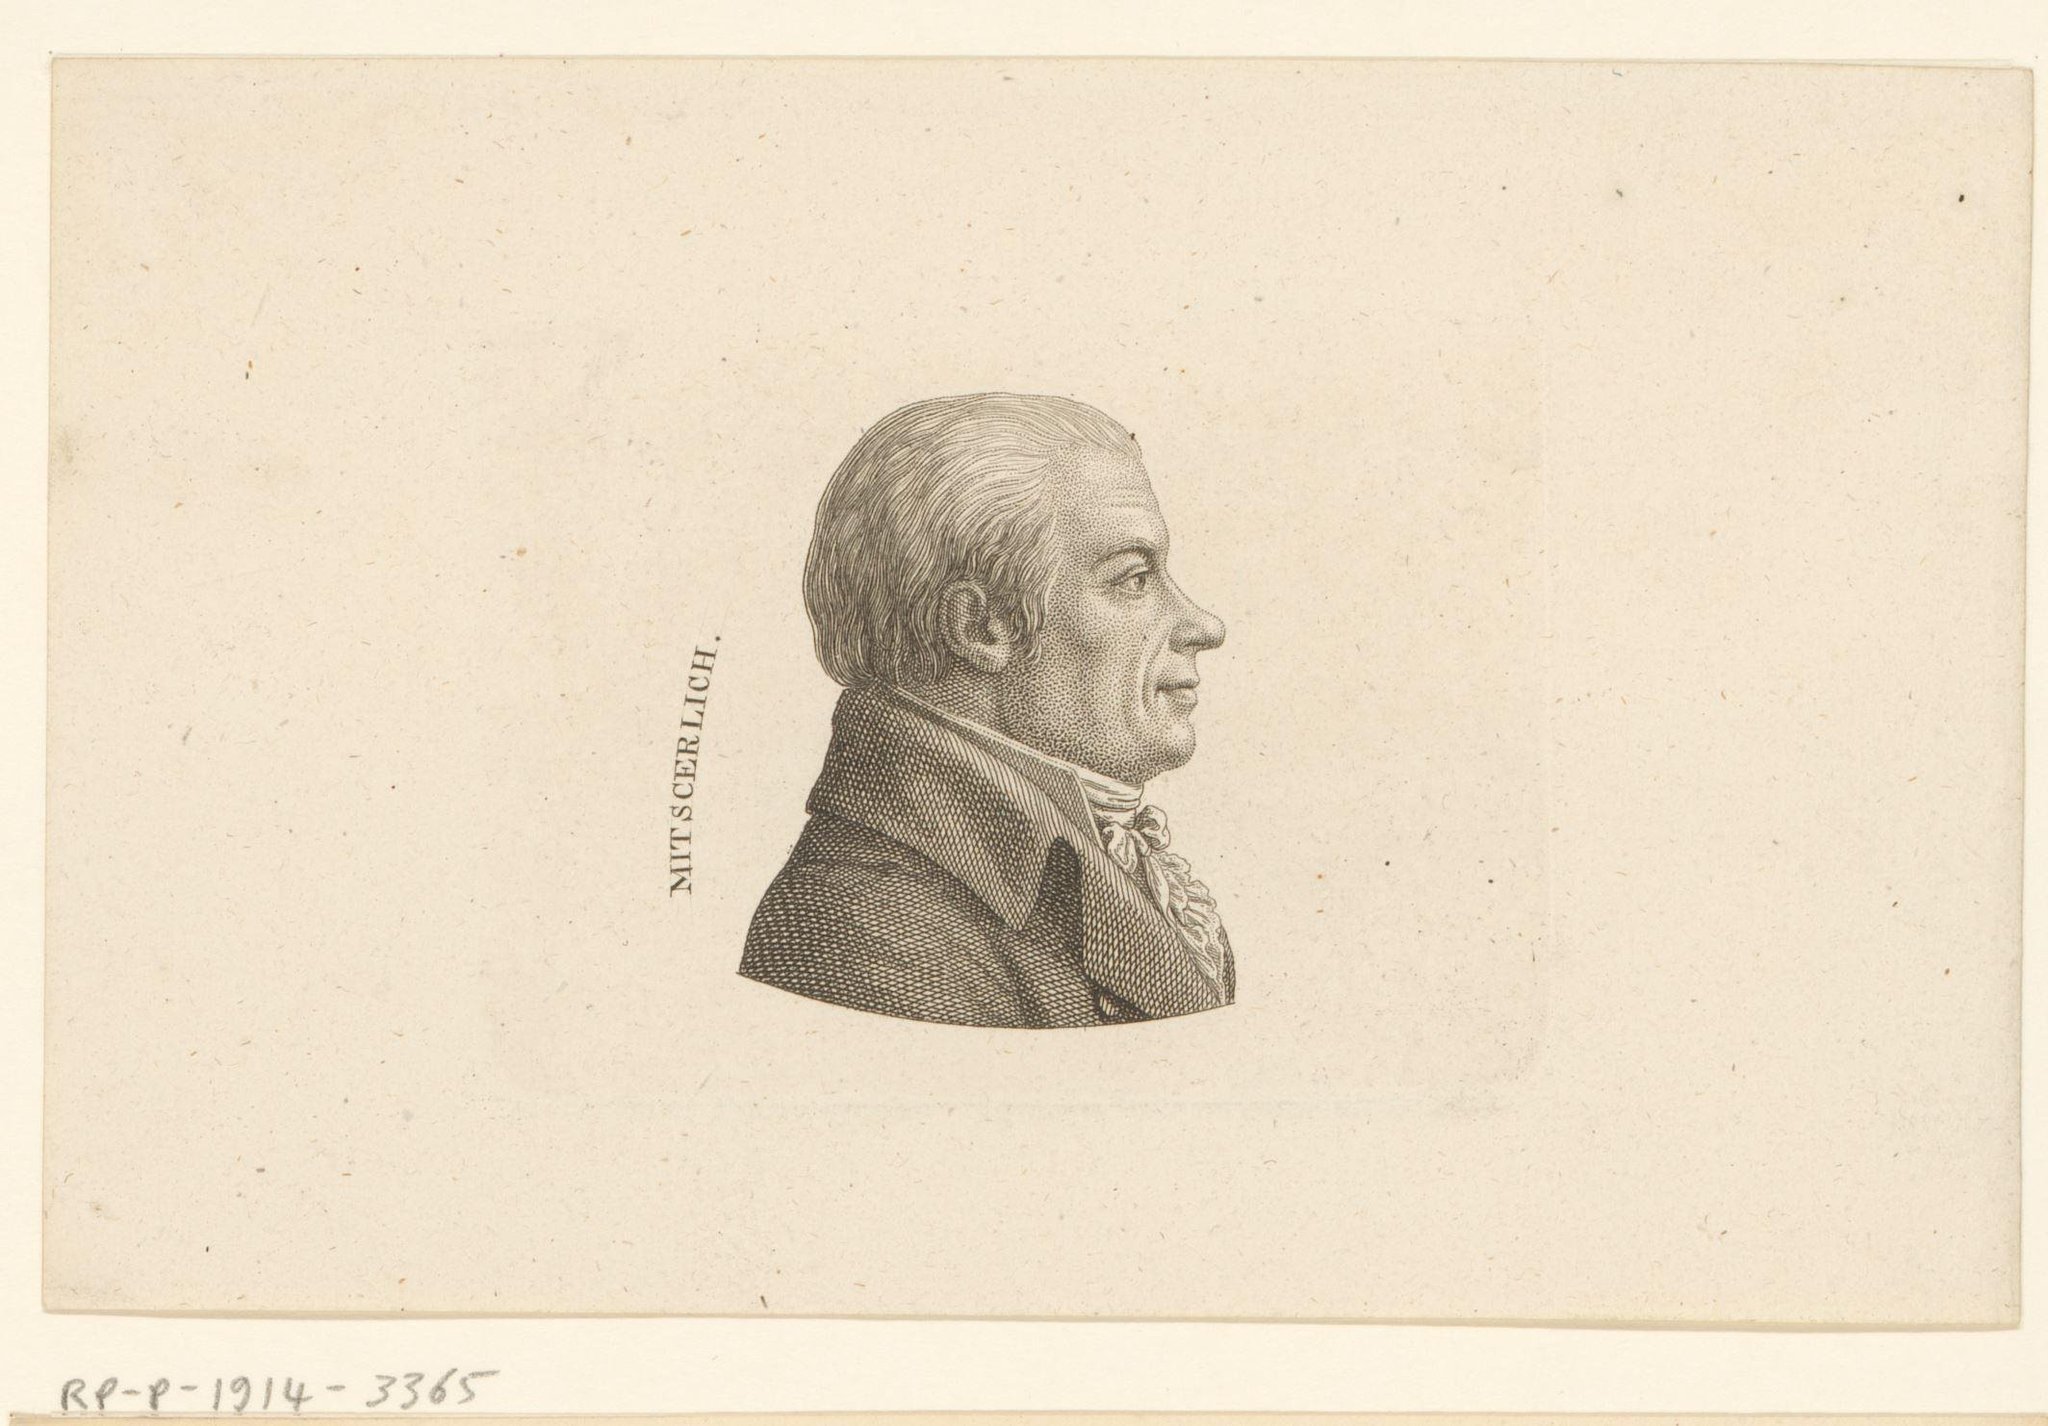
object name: print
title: Portret van Eilhard Mitscherlich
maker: ernst ludwig riepenhausen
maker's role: print maker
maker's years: 1765-1840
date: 1804-1840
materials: paper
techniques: engraving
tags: historical persons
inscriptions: collector's mark: Lugt 2228